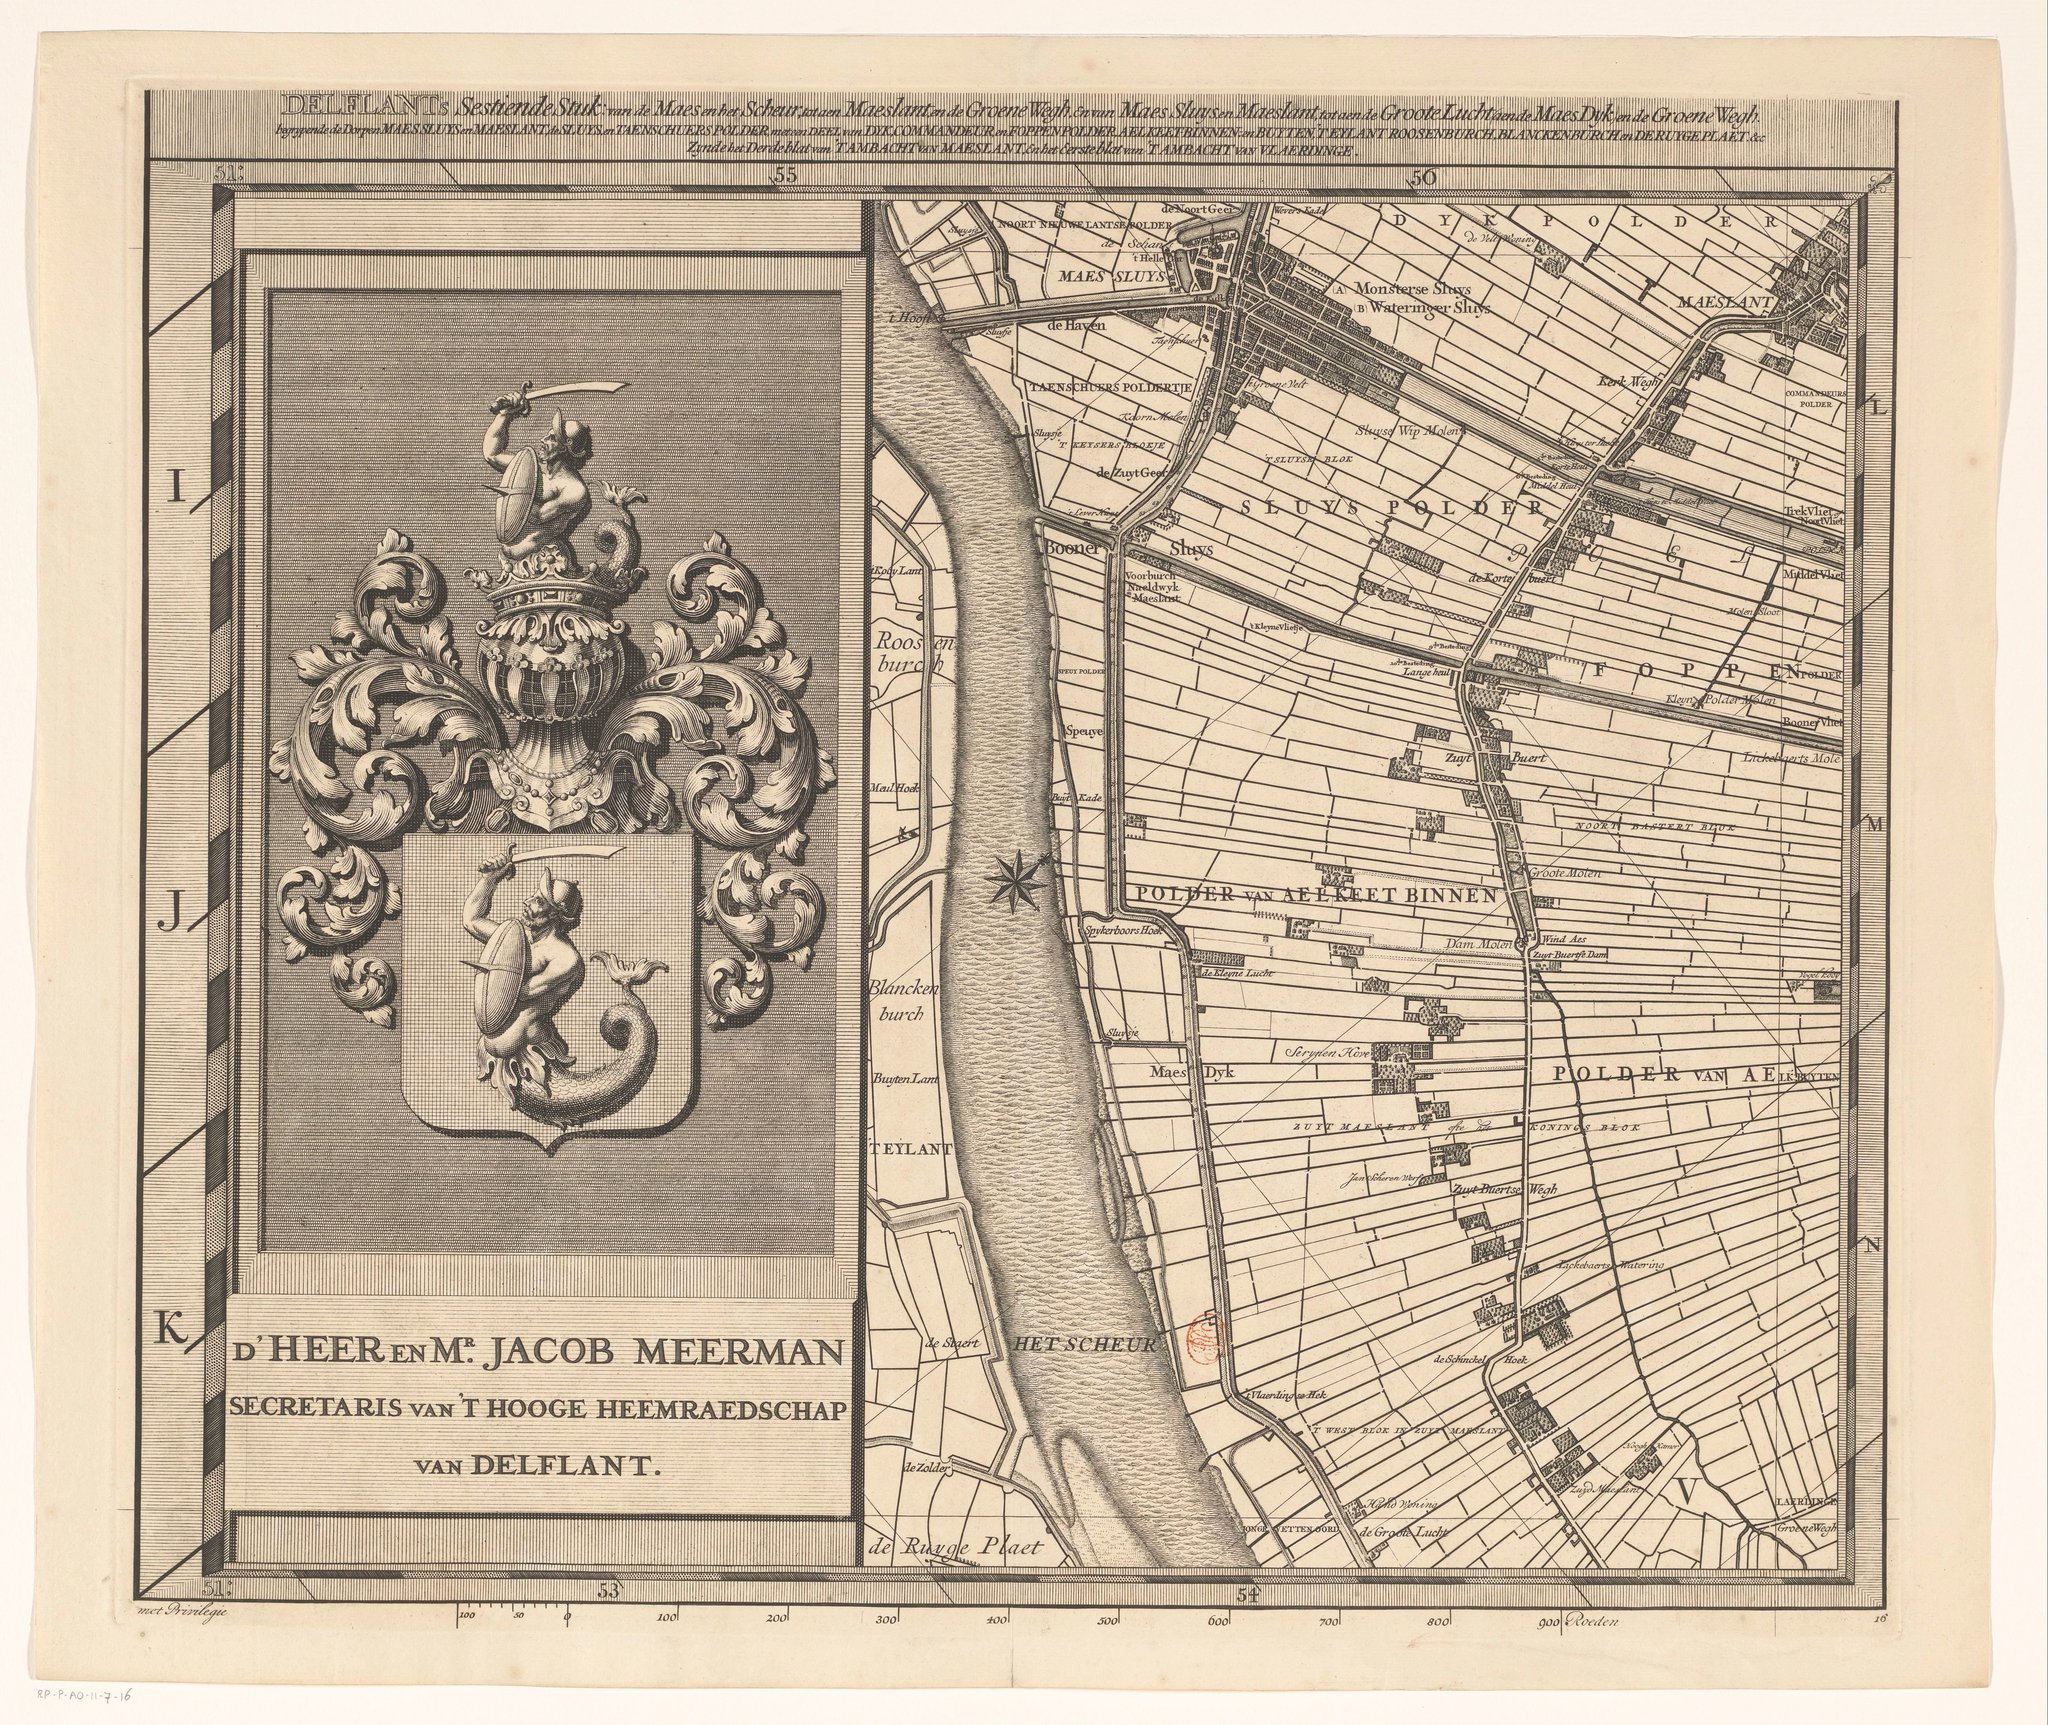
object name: print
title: Kaart van het Hoogheemraadschap van Delfland (zestiende deel)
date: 1712-1735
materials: paper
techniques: engraving, etching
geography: delft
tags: maps of cities, armorial bearing, heraldry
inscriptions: collector's mark: Lugt 2228, collector's mark: Lugt 195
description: Onderdeel van de grote wandkaart 'T Hooge Heemraedschap van Delflant. De kaart zelf bestaat uit vijfentwintig bladen, de titelstrook is gedrukt van twee platen. Meerdere prentmakers hebben aan deze kaart gewerkt. In volgorde van meest gewerkte dagen zijn dit: Luggert van Anse (1091 dagen), Thomas Doesburgh (952 dagen), Jacobus Deur (806 dagen), Johannes Deur (683 dagen) en Pieter Sluyter (151 dagen). Sluyter was verantwoordelijk voor de versieringen, de anderen voor de rest. Wie precies aan welk blad heeft gewerkt is niet duidelijk. Pieter Haringh had het ontwerp voor de wapenschilden geleverd en Arnold Houbraken het ontwerp voor de rest van de versieringen. Het drukken, uitgeven en verkopen van de kaart lag, zoals blijkt uit het privilege, in handen van het hoogheemraadschap. Voor zover bekend is de kaart in zijn geheel twee keer gedrukt, in 1712 en 1735. Het hoogheemraadschap beheerde de voorraad kaarten voor verkoop. In een aantal atlassen van Covens & Mortier (Nieuwe atlas inhoudende de vier gedeeltens der waereld (...). 5 delen. Amsterdam: Covens & Mortier, s.a. [1721-1759], dl. 3) zijn de zevenentwintig bladen van de kaart en de overzichtskaart opgenomen. Het is dus vermoedelijk niet zo dat de kaart voor deze atlassen opnieuw werd gedrukt. Waarschijnlijk werd een aantal exemplaren bij het hoogheemraadschap afgenomen.